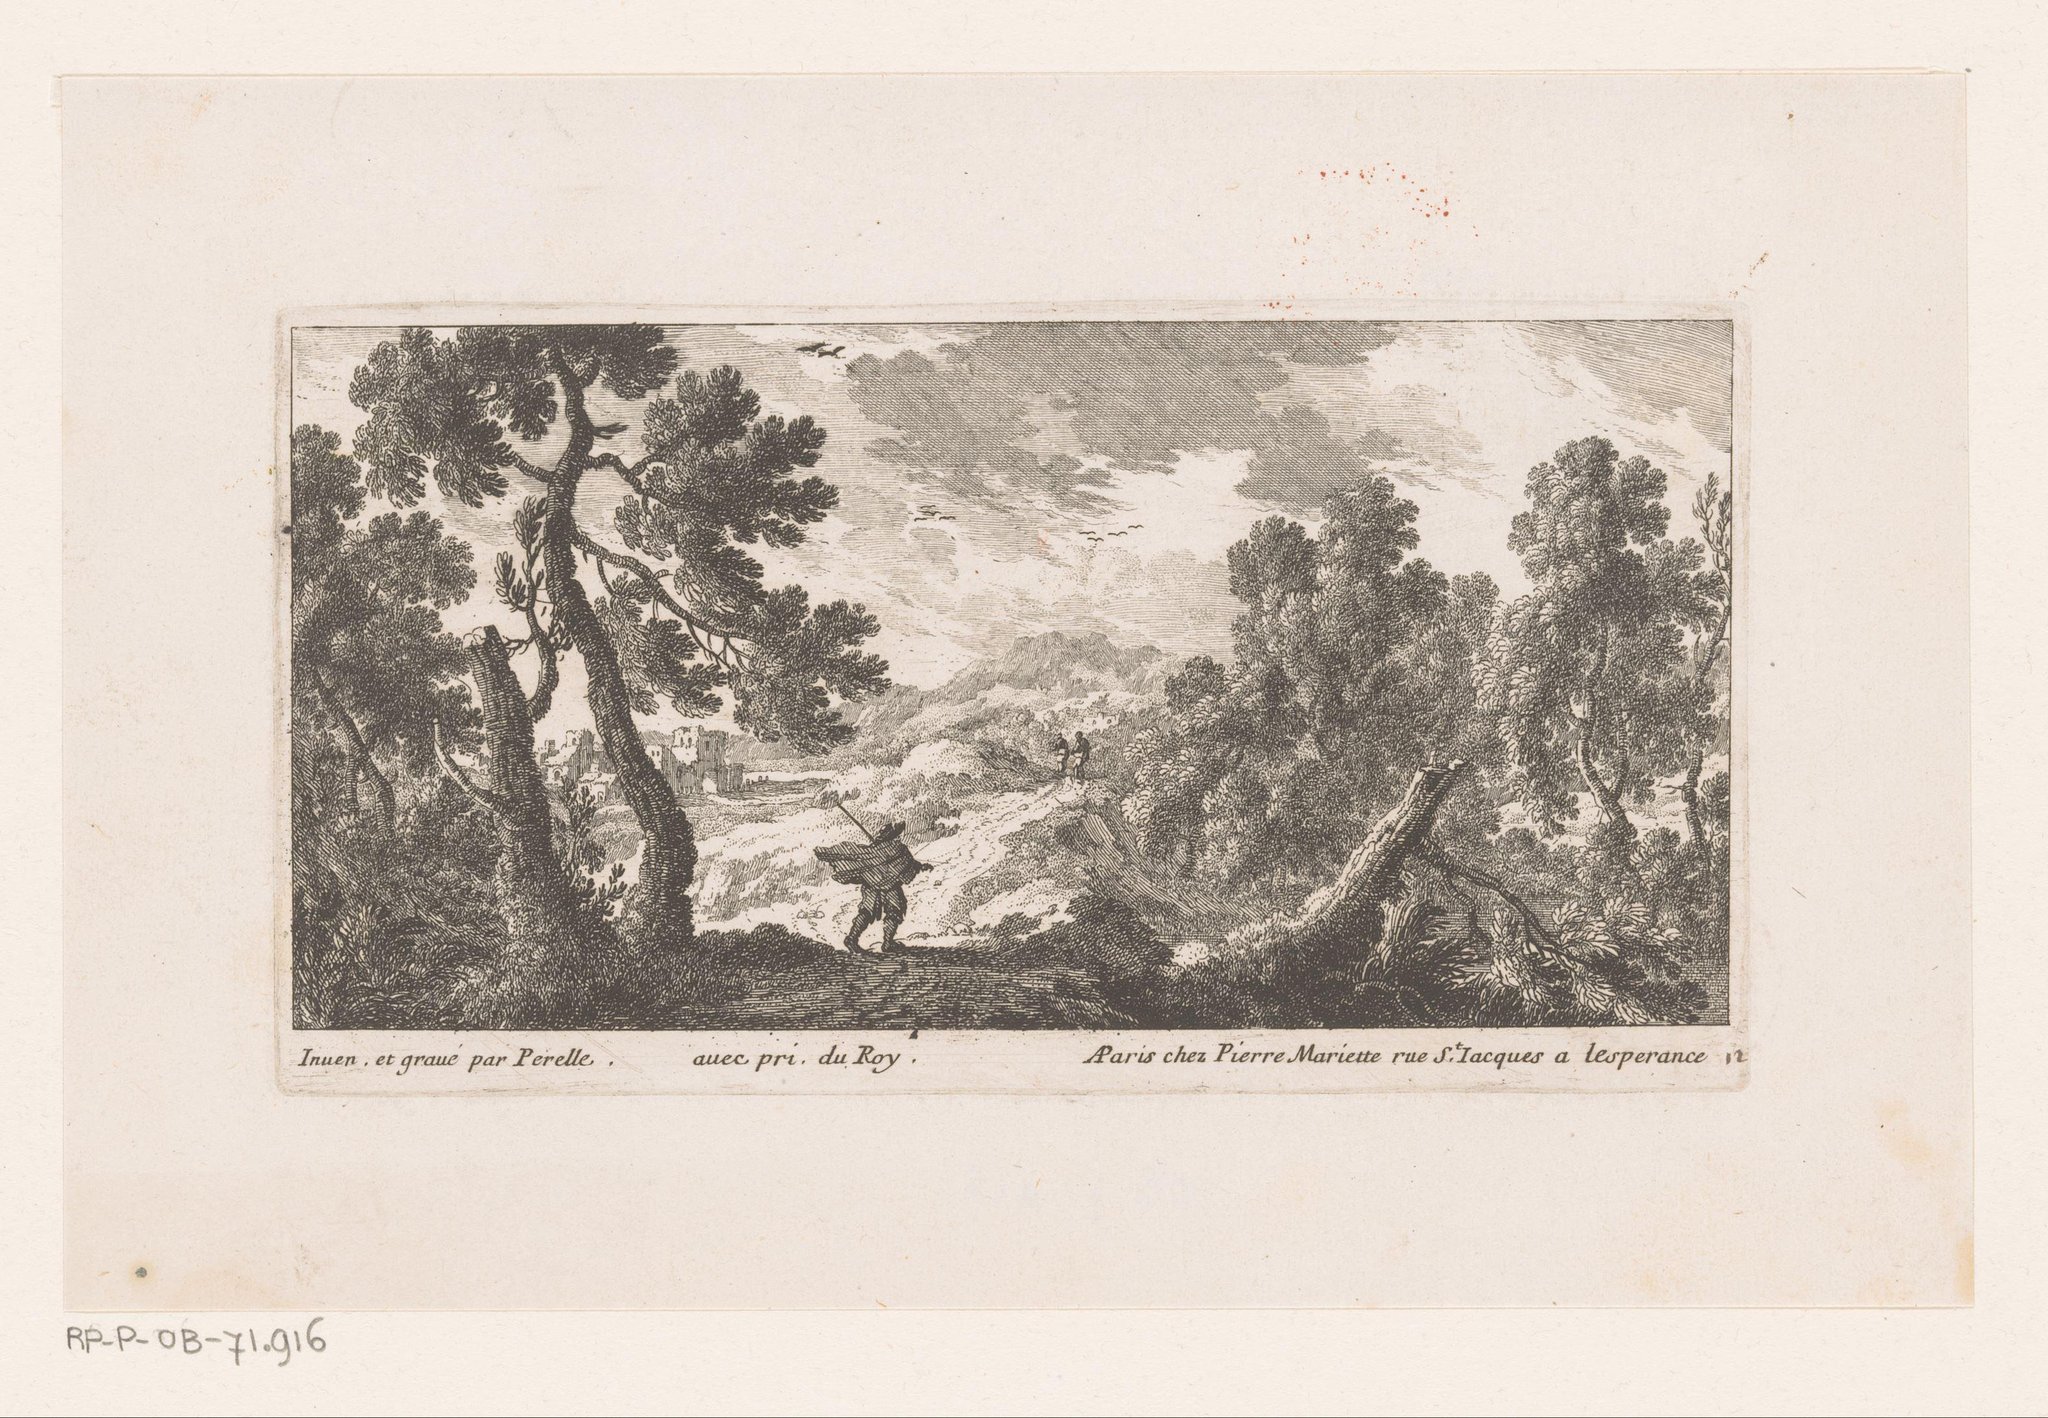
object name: print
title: Landschap met man met wapperende mantel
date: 1613-1695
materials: paper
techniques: etching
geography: france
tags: landscapes, storm on land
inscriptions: collector's mark: Lugt 240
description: Prenten met het signatuur 'Perelle' kunnen zowel door vader Gabriel als door zonen Nicolas en Adam gemaakt zijn.